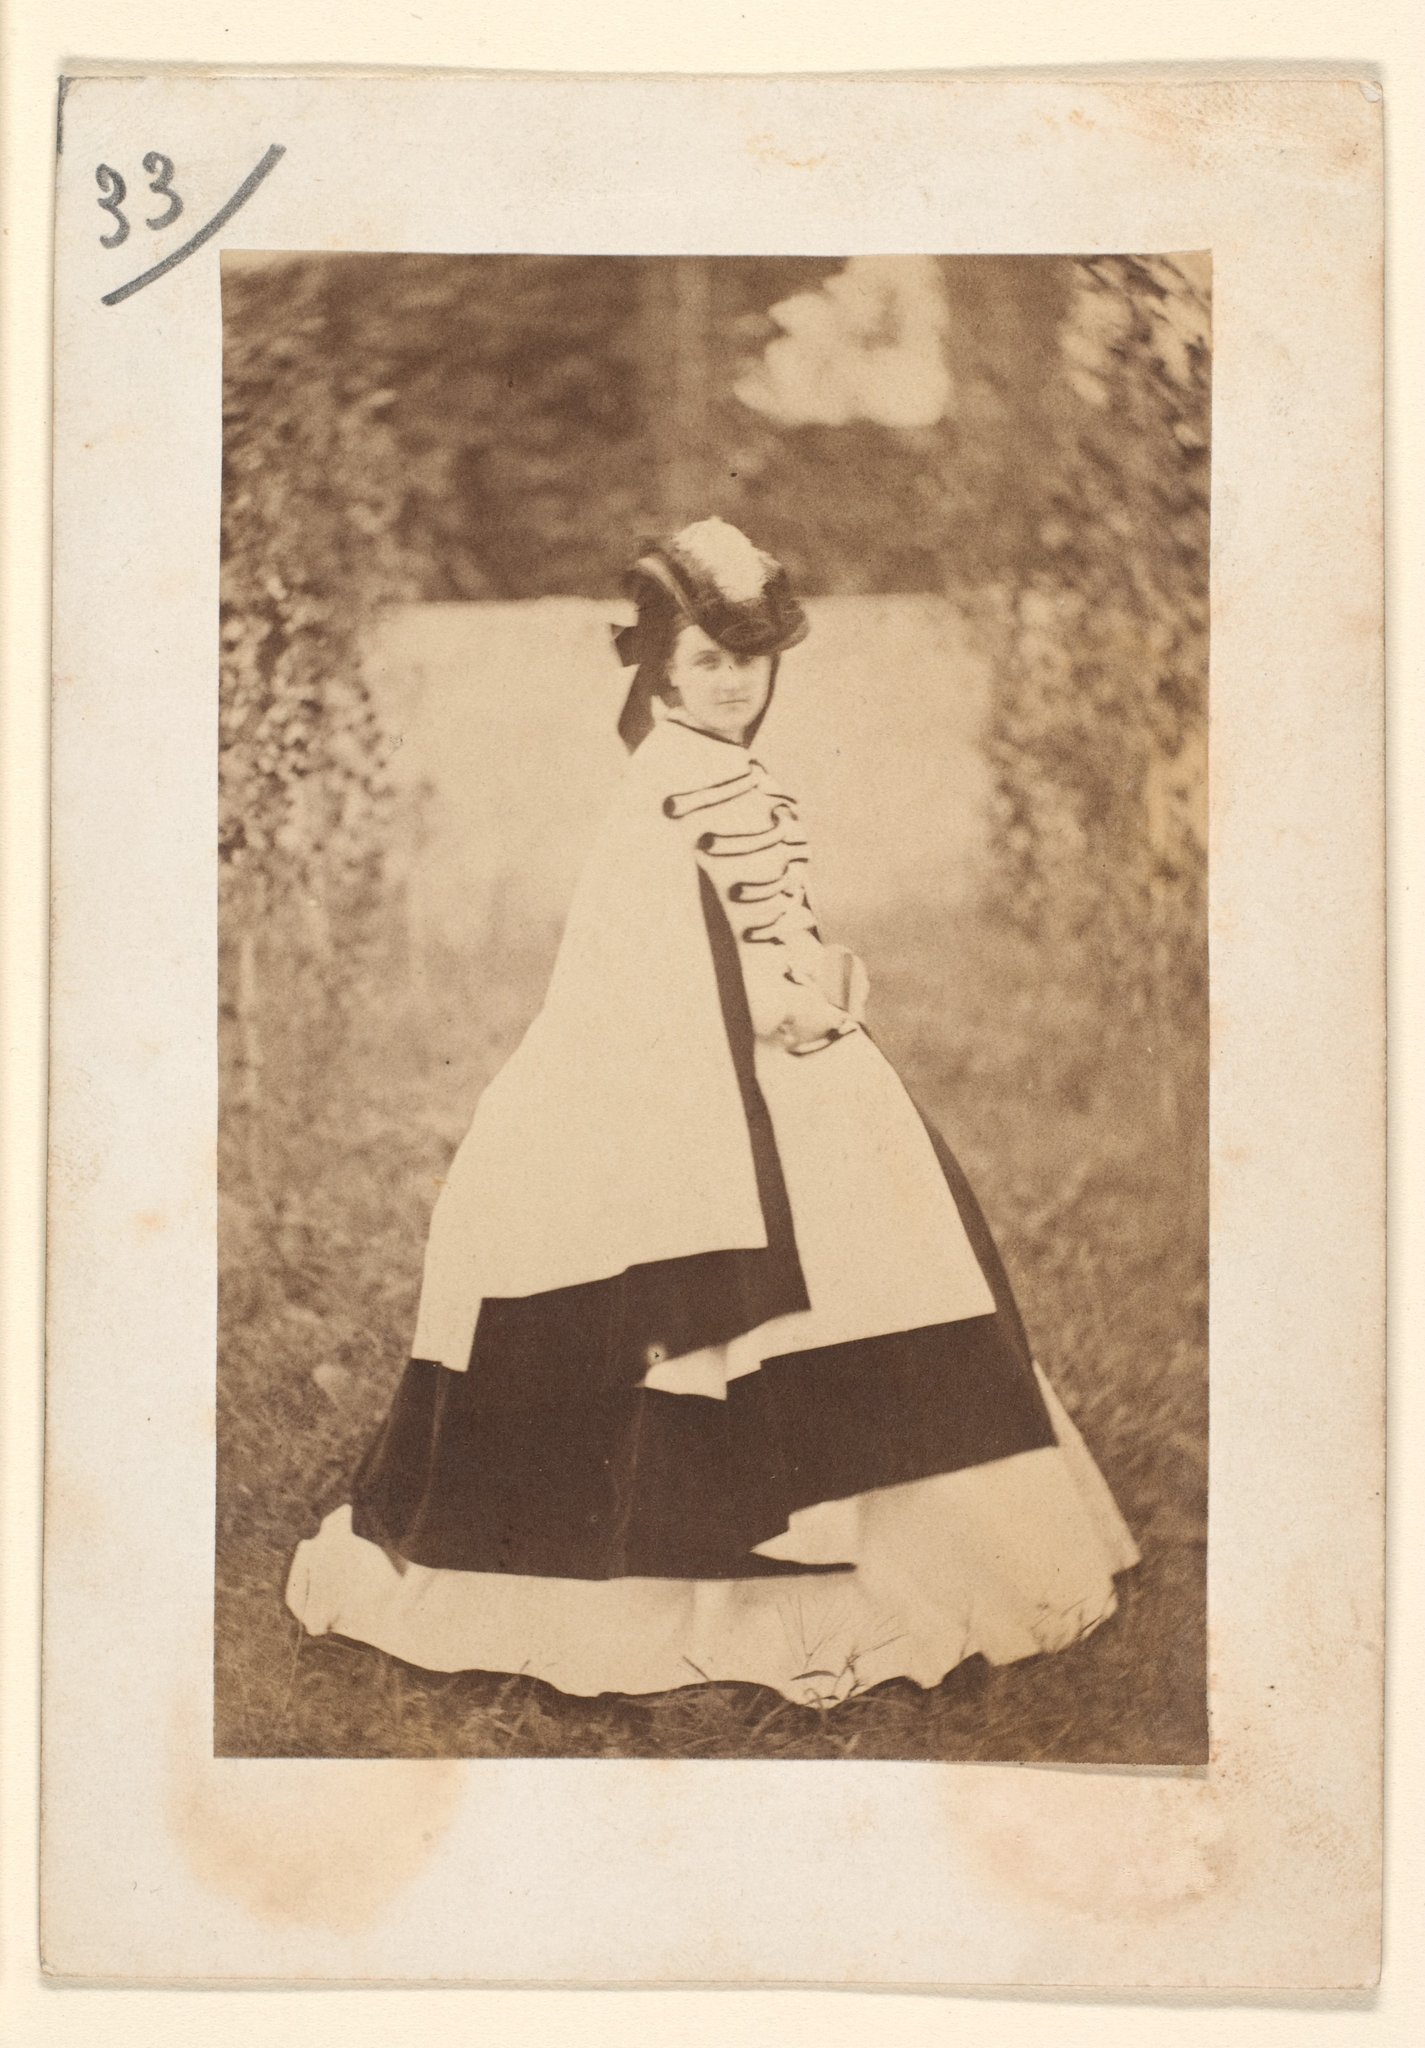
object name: photograph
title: La robe d'été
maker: pierre-louis pierson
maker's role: artist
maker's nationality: french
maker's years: 1822-1913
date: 1860-1869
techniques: albumen silver print, glass negative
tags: portraits,women